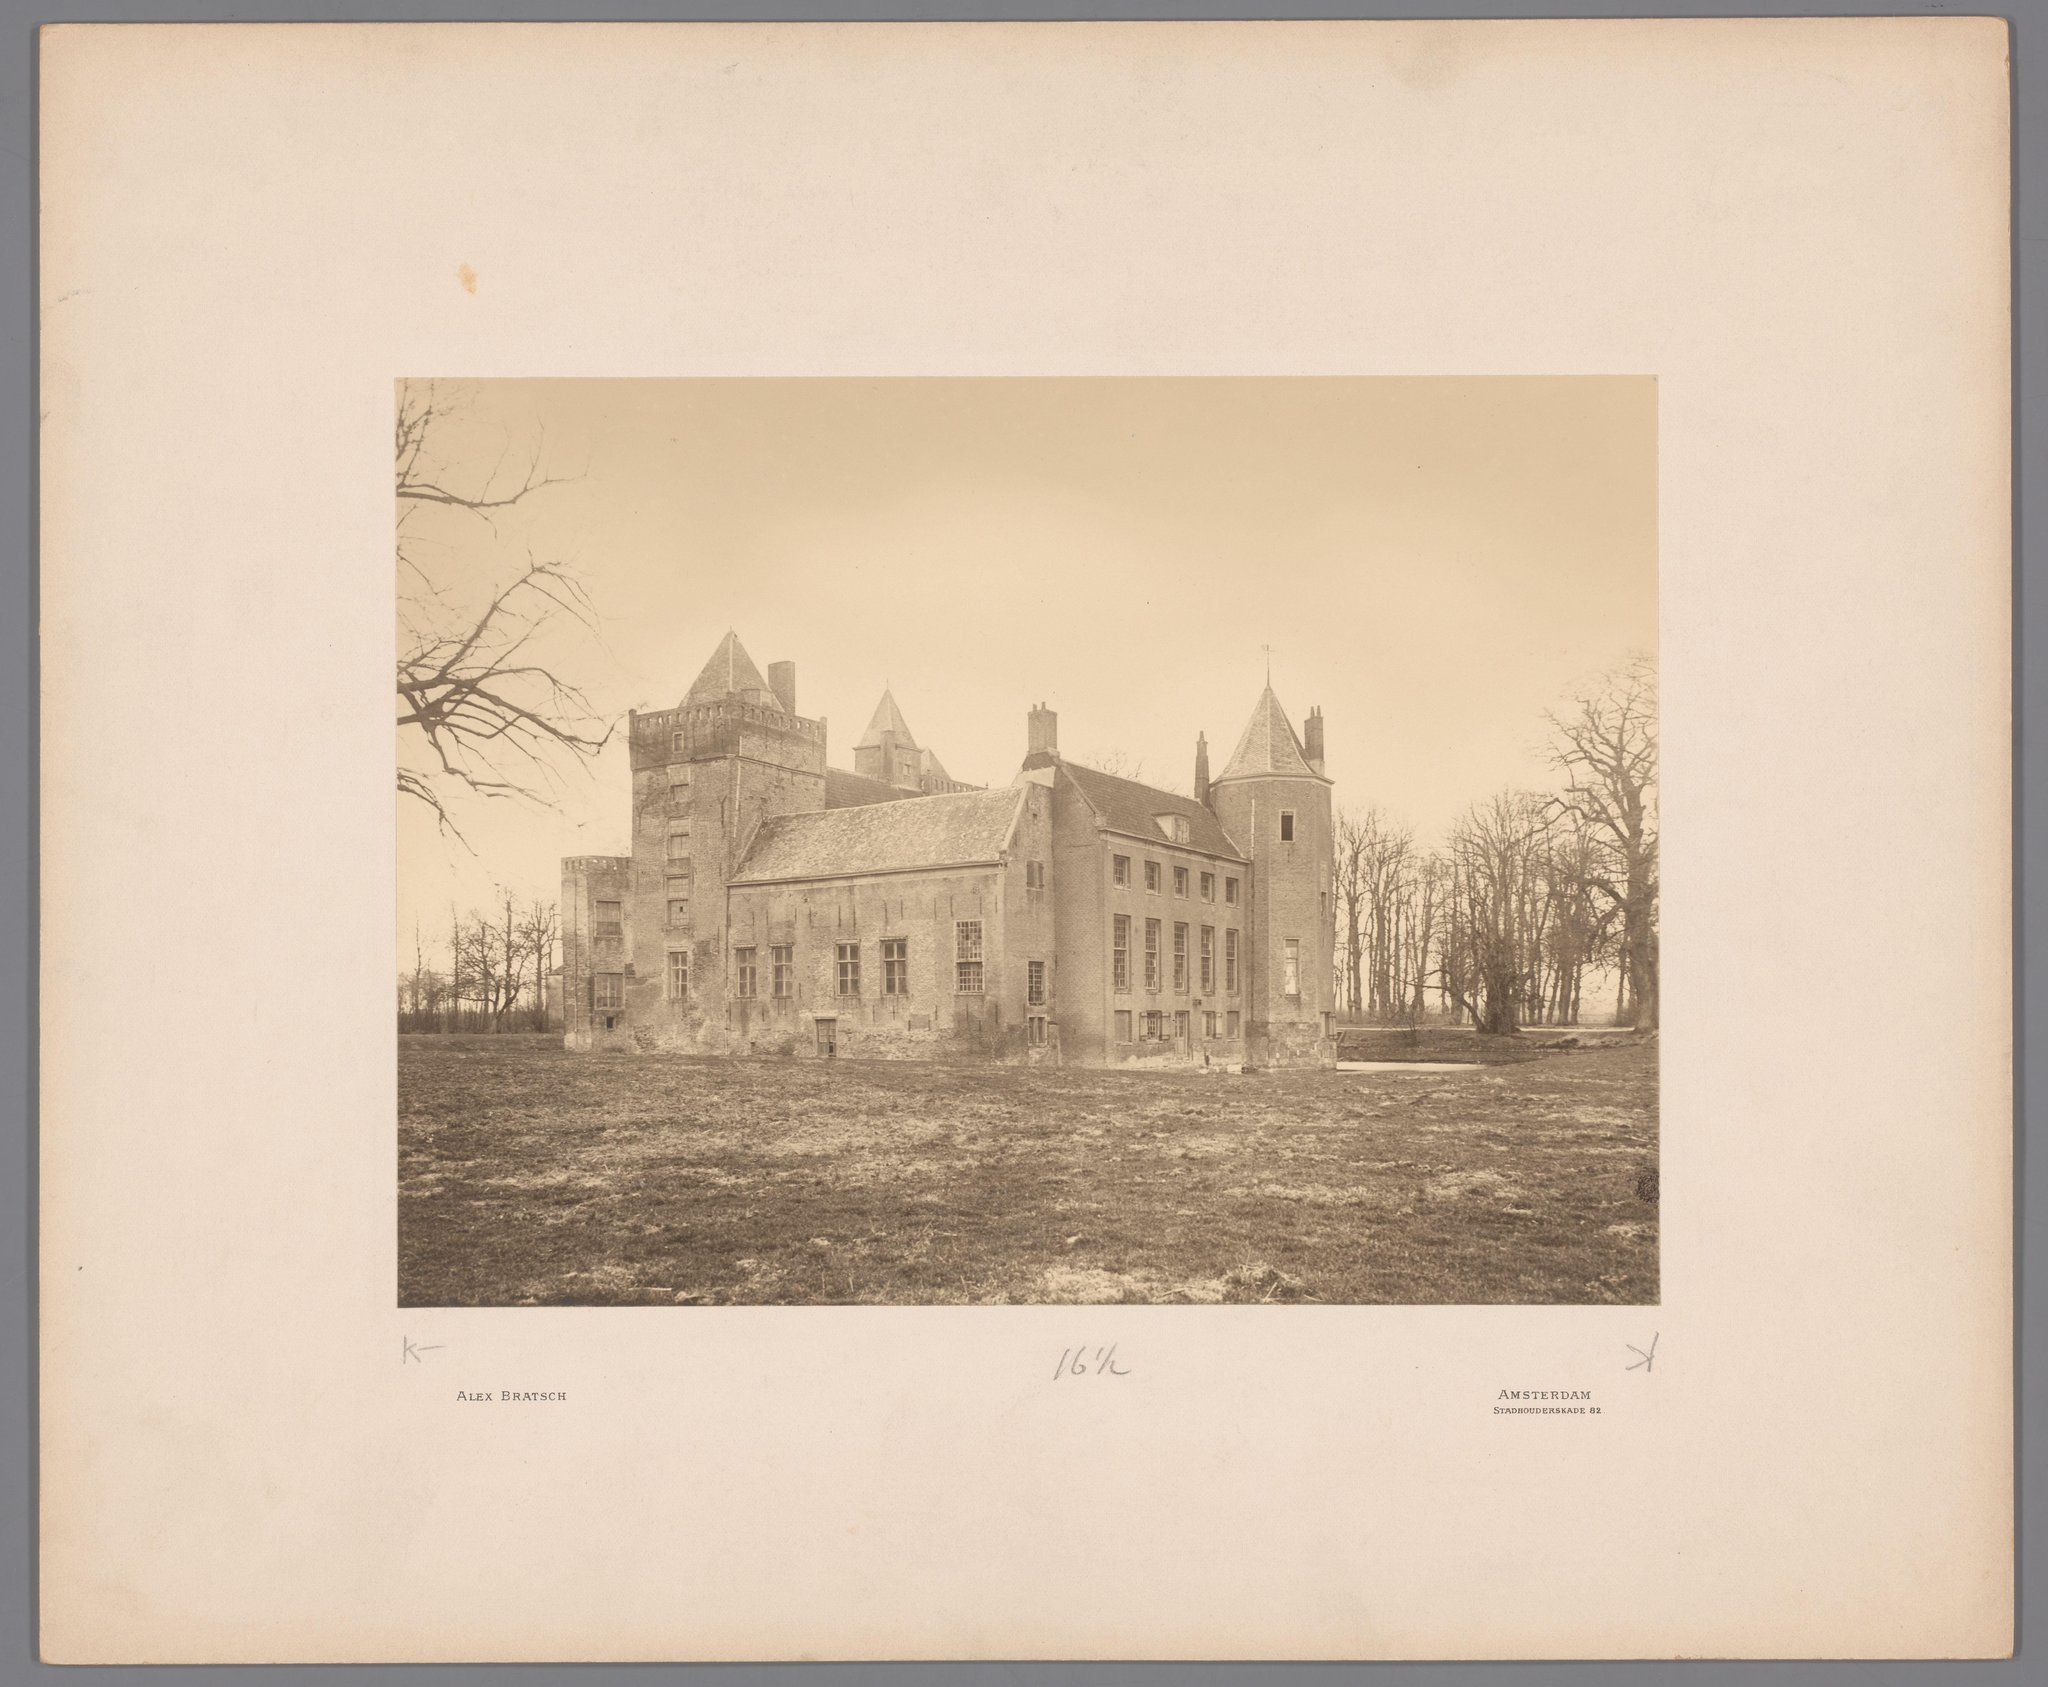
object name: photograph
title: Slot Assumburg bij Heemskerk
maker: alex bratsch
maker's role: fotograaf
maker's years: 1869-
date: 1910-1930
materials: cardboard, photographic support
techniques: gelatin silver print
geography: heemskerk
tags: castle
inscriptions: annotation, annotation: ‘16 1/2’, address: ‘Amsterdam/ Stadhouderskade 82’